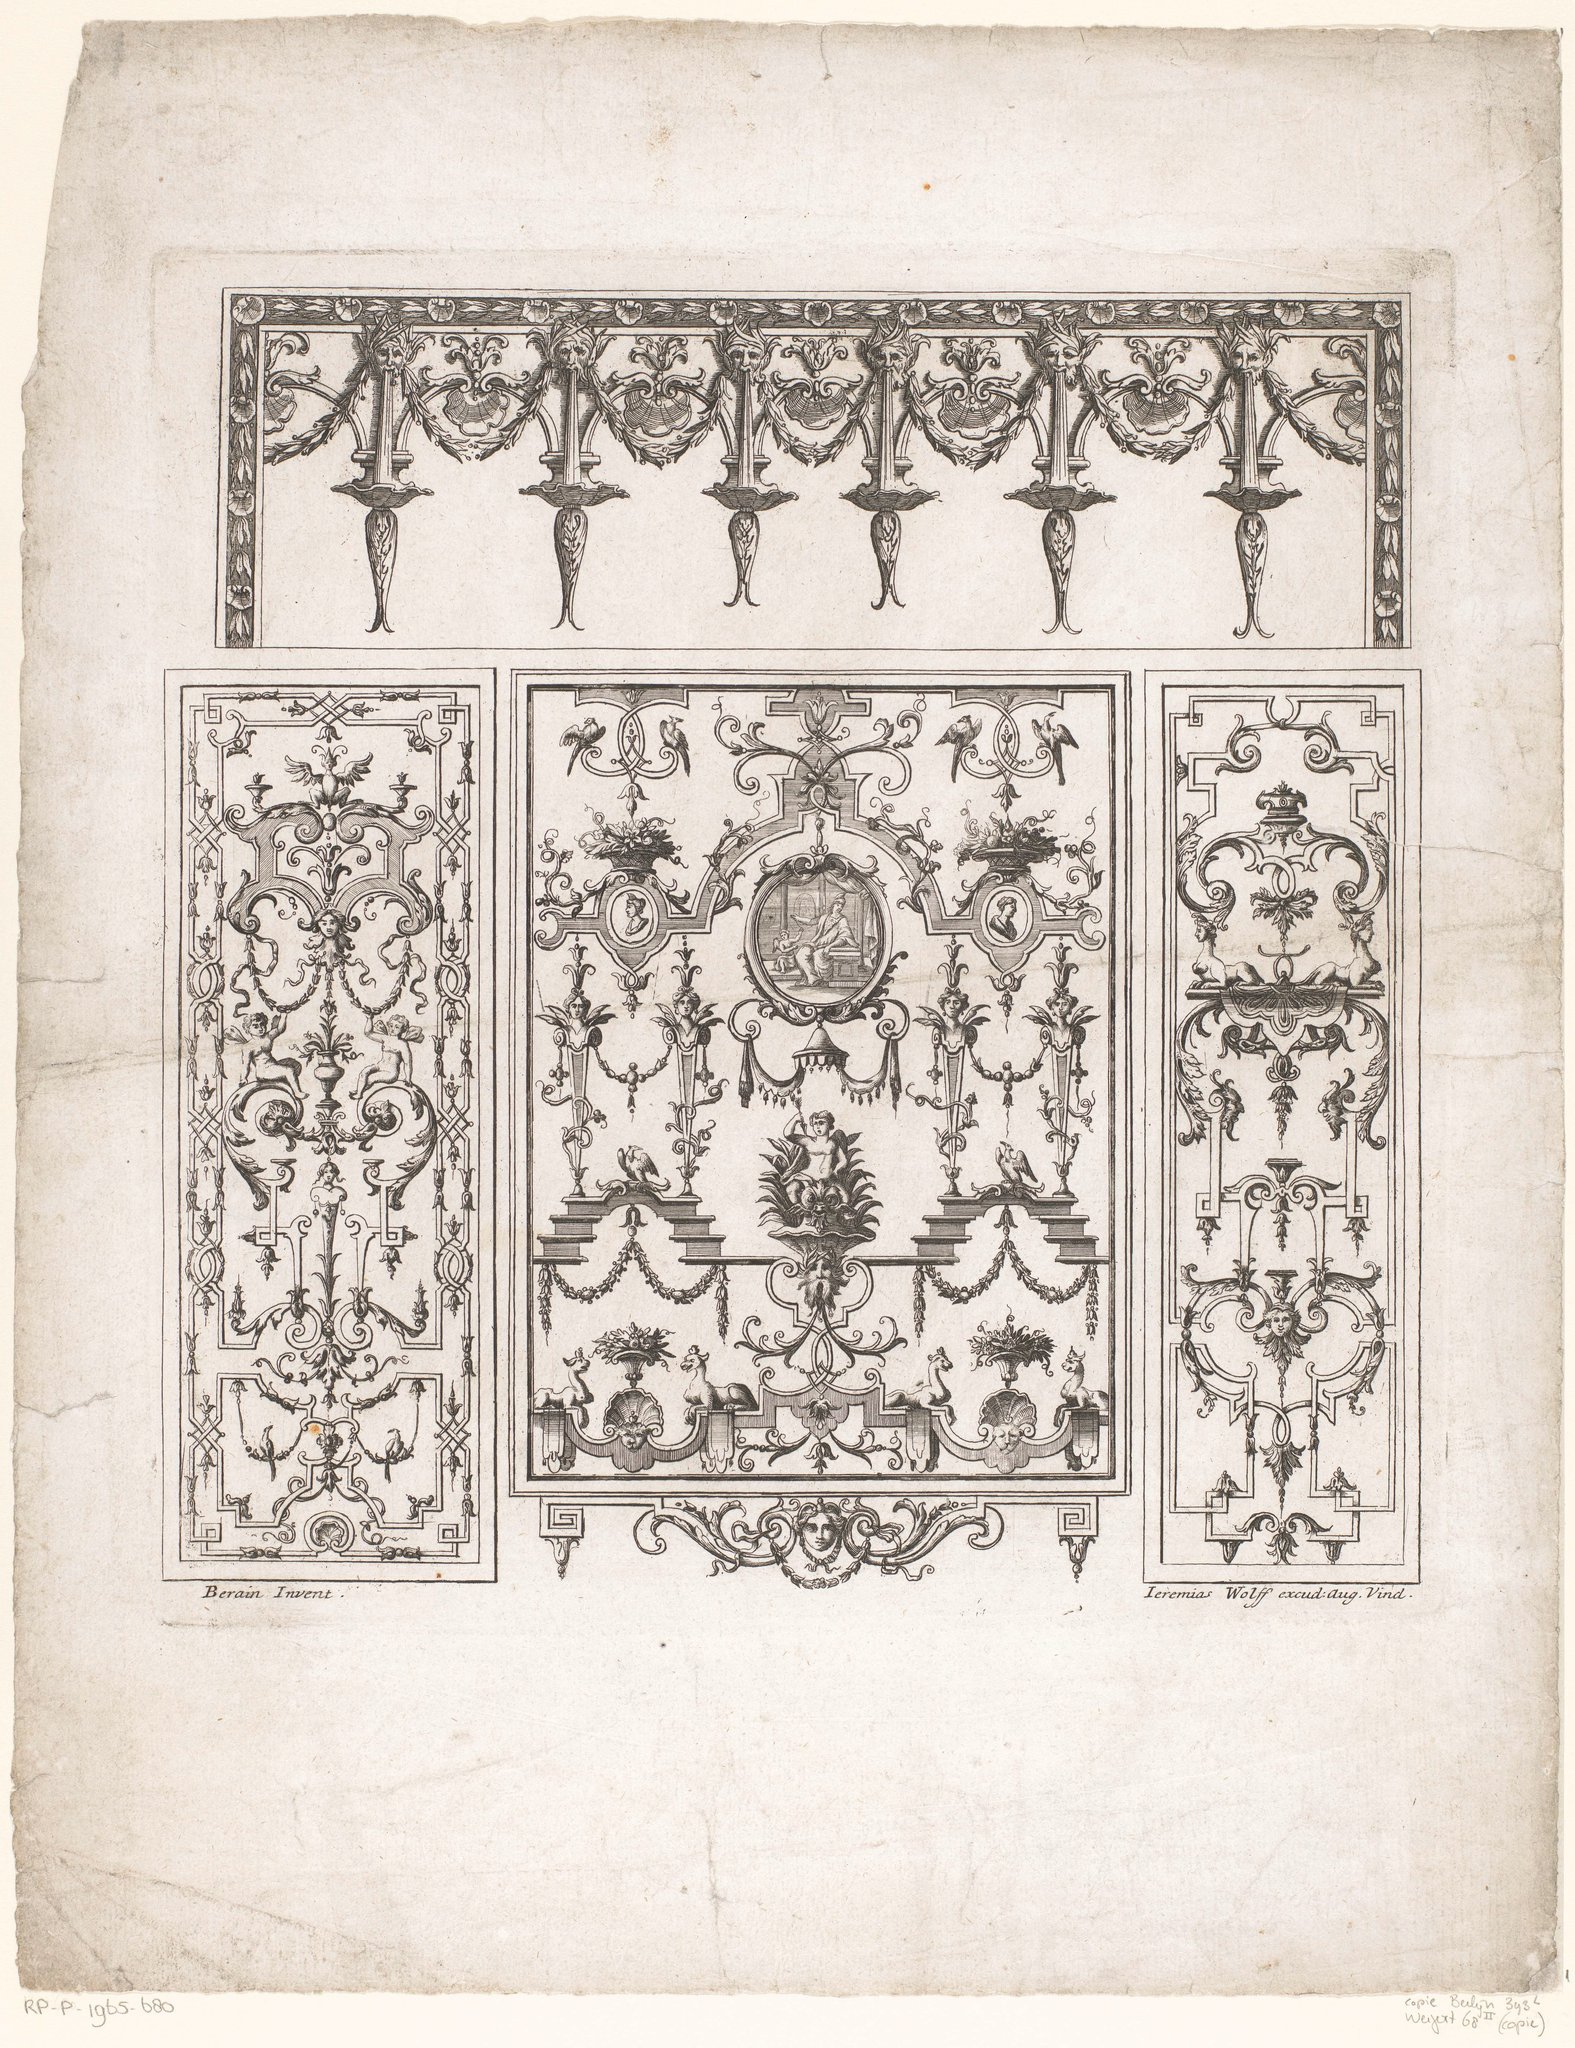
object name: print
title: Composities met Minerva en putto op dolfijn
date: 1686-1724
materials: paper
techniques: etching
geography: augsburg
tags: dolphin ~ ornament, (story of) minerva (pallas, athena), frequently used ornamental compositions, cupids: 'amores', 'amoretti', 'putti'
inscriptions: collector's mark: Lugt 2228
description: Decoratieve composities met vlechtwerk op vier panelen. Aan de bovenzijde arcades met schelpmotieven en maskers. Links onder vlechtwerk en putti. Midden onder vlechtwerk, een arcade, kariatiden, een medaillon met Minerva en een putto zittend op een dolfijn. Rechts onder vlechtwerk en sfinxen.